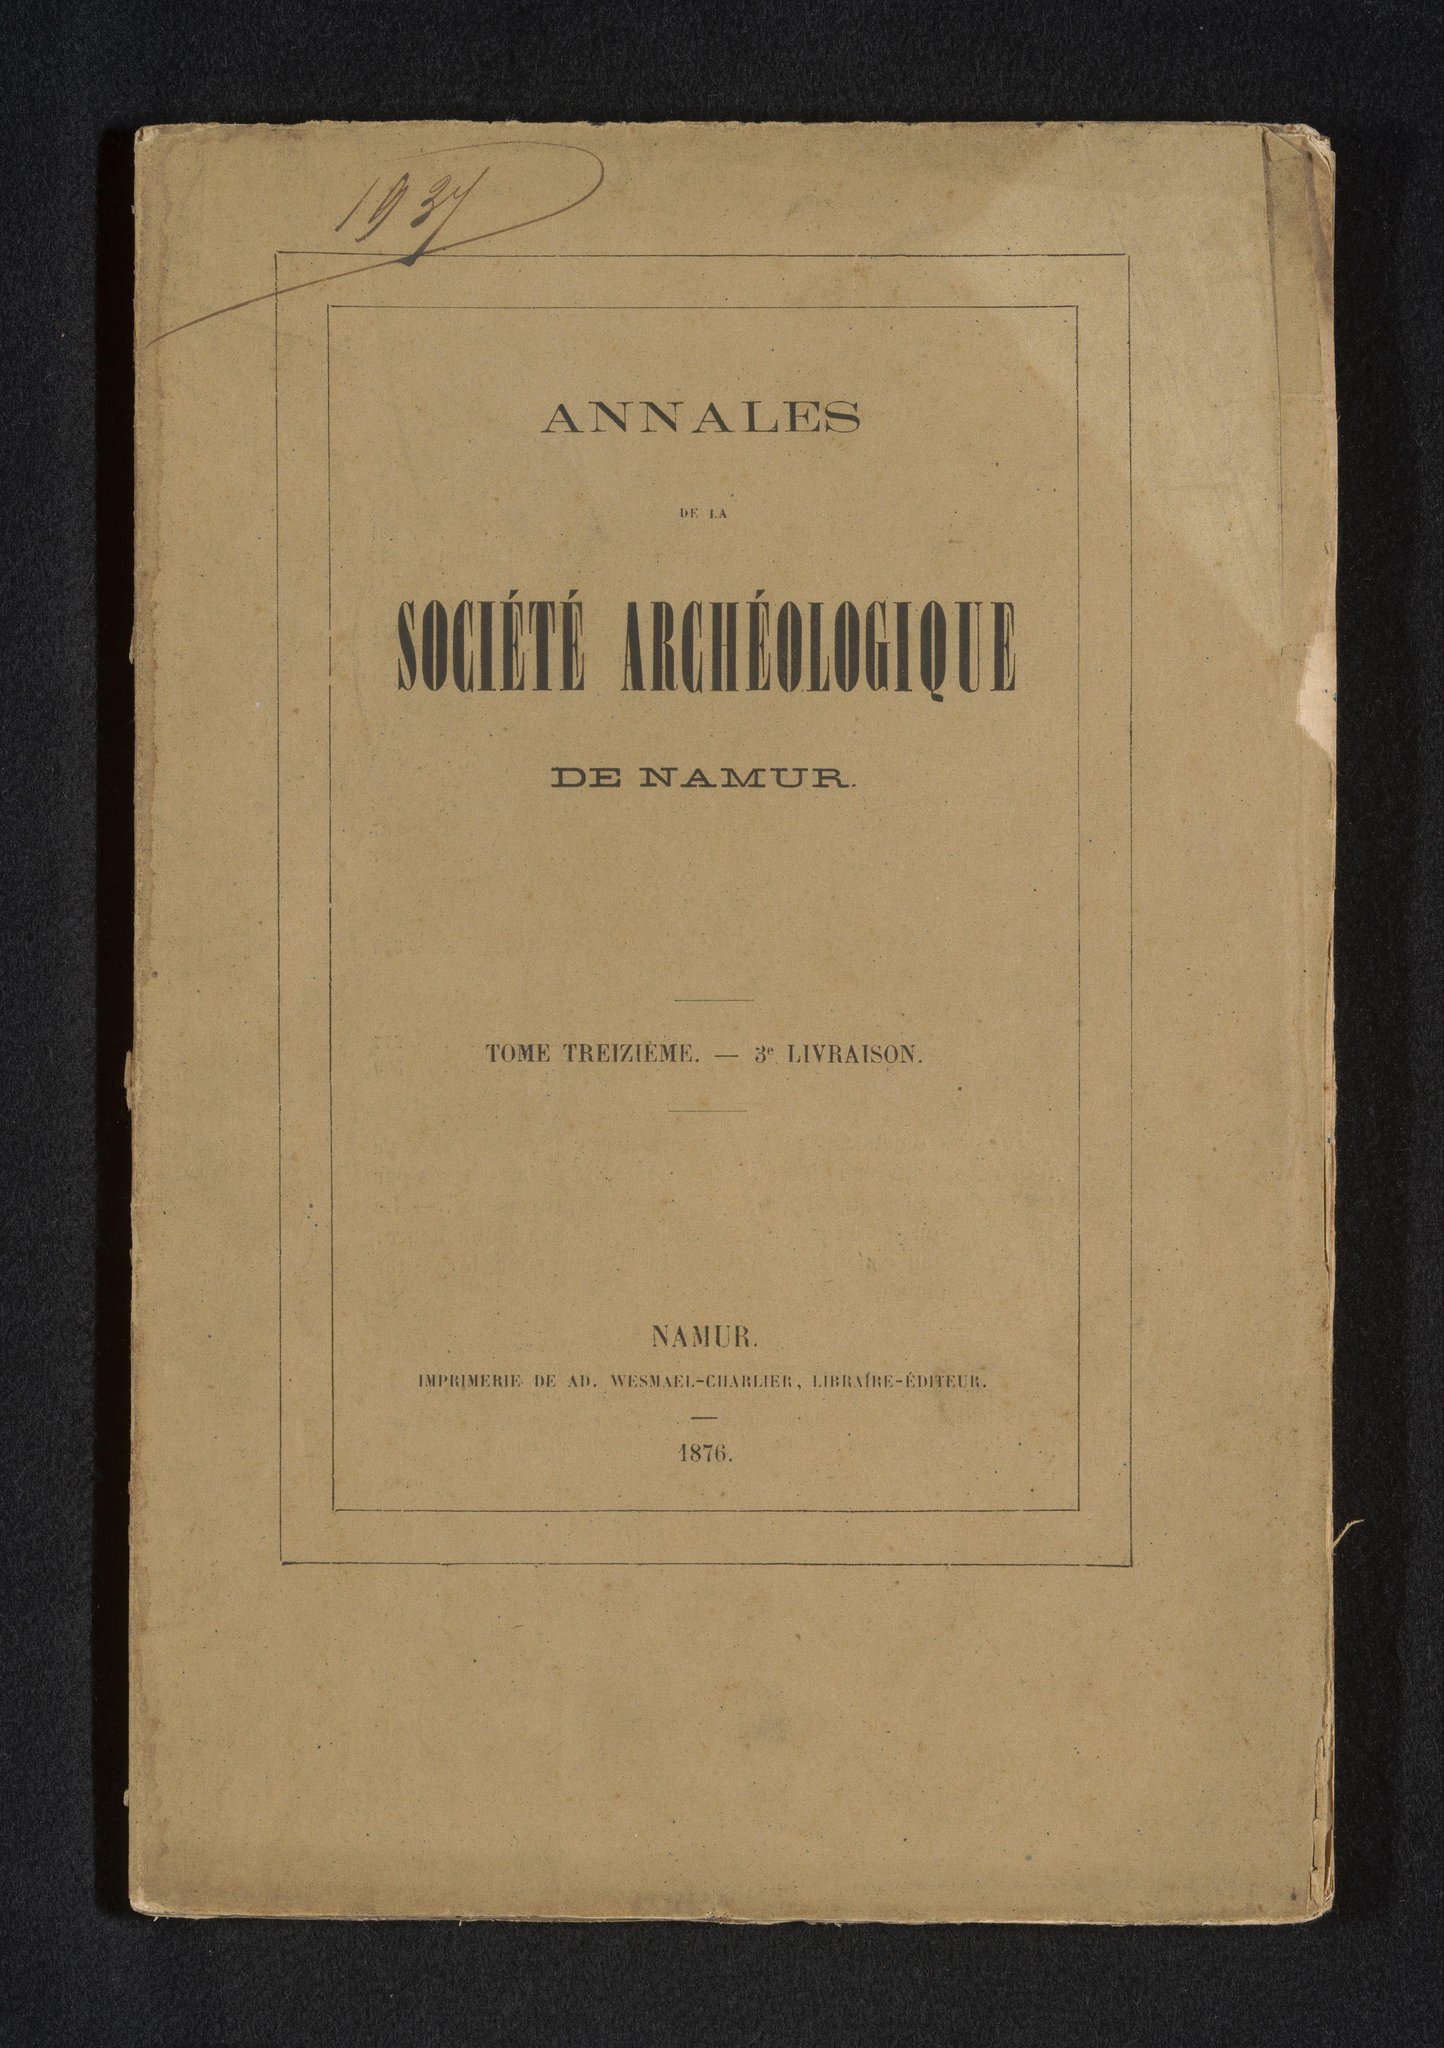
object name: book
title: Annales de la Société archéologique de Namur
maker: adolphe wesmael-charlier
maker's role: printer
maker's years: 1842-1906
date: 1875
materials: paper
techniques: lithograph, photolithography, printing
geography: namur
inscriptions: stamp: ‘administ communale de tirlemont’, annotation: ‘OCT/ 1990’